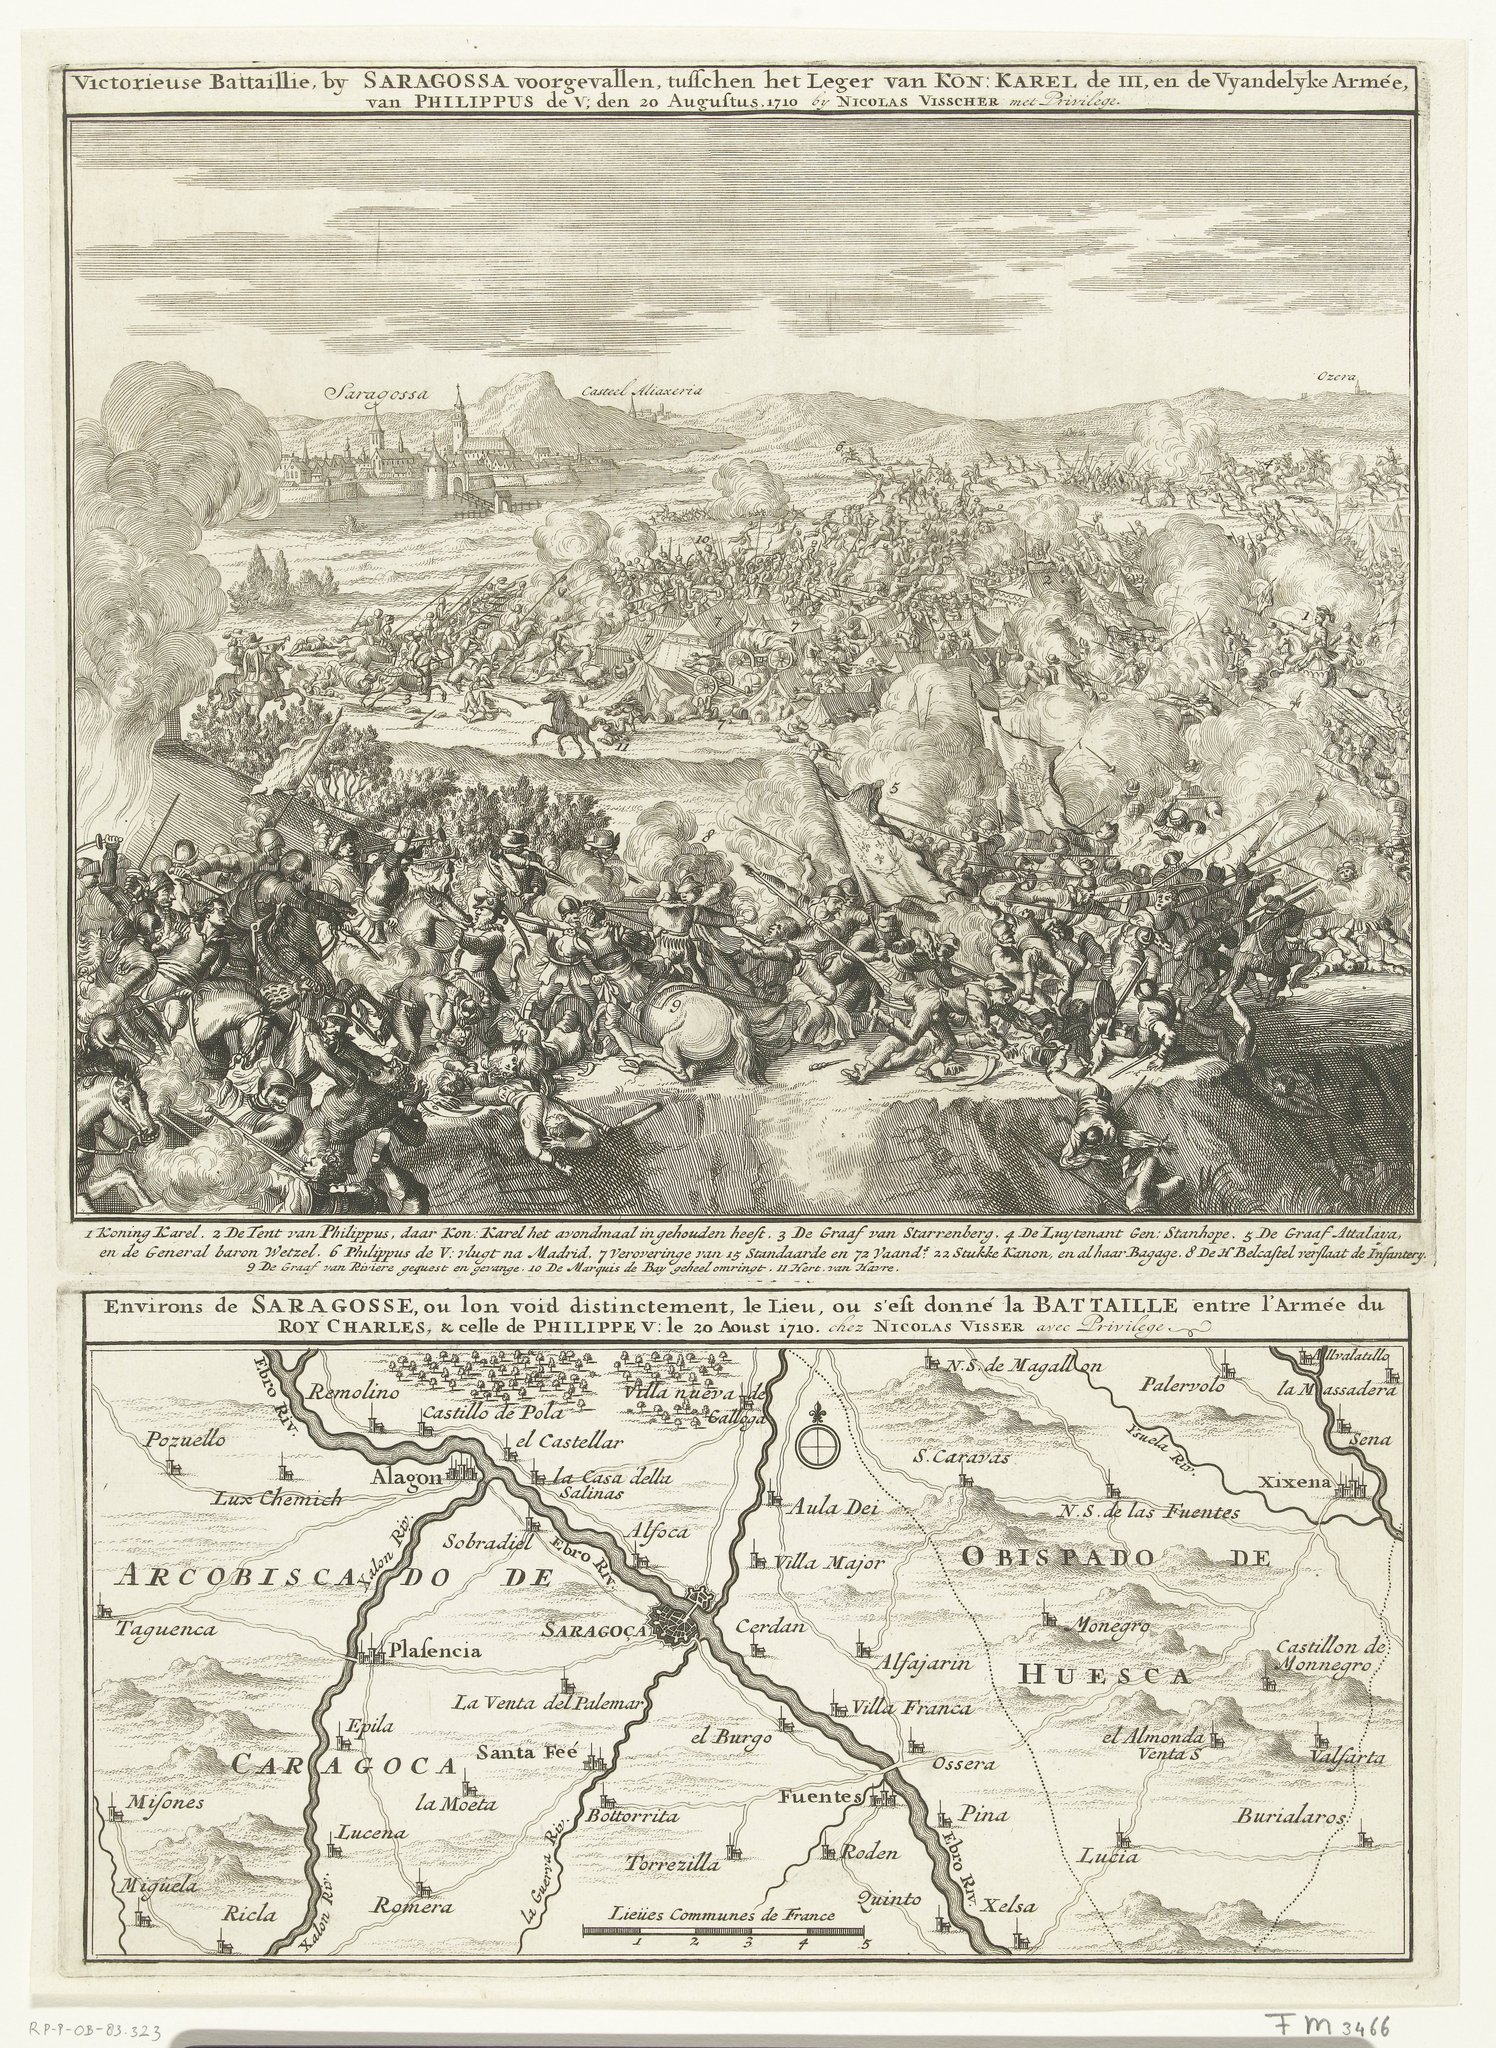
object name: print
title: Overwinning op het Franse leger bij Zaragoza, 1710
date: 1710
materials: paper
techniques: etching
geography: northern netherlands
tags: filips v (koning van spanje), vienna, charles vi (holy roman emperor), maps of separate countries or regions, battle (+ land forces)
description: Blad met een voorstelling en een kaart van de overwinning van de Geallieerden op het Franse leger in de slag bij Zaragoza, 20 augustus 1710. De voorstellingen gedrukt van twee platen onder elkaar op één blad.